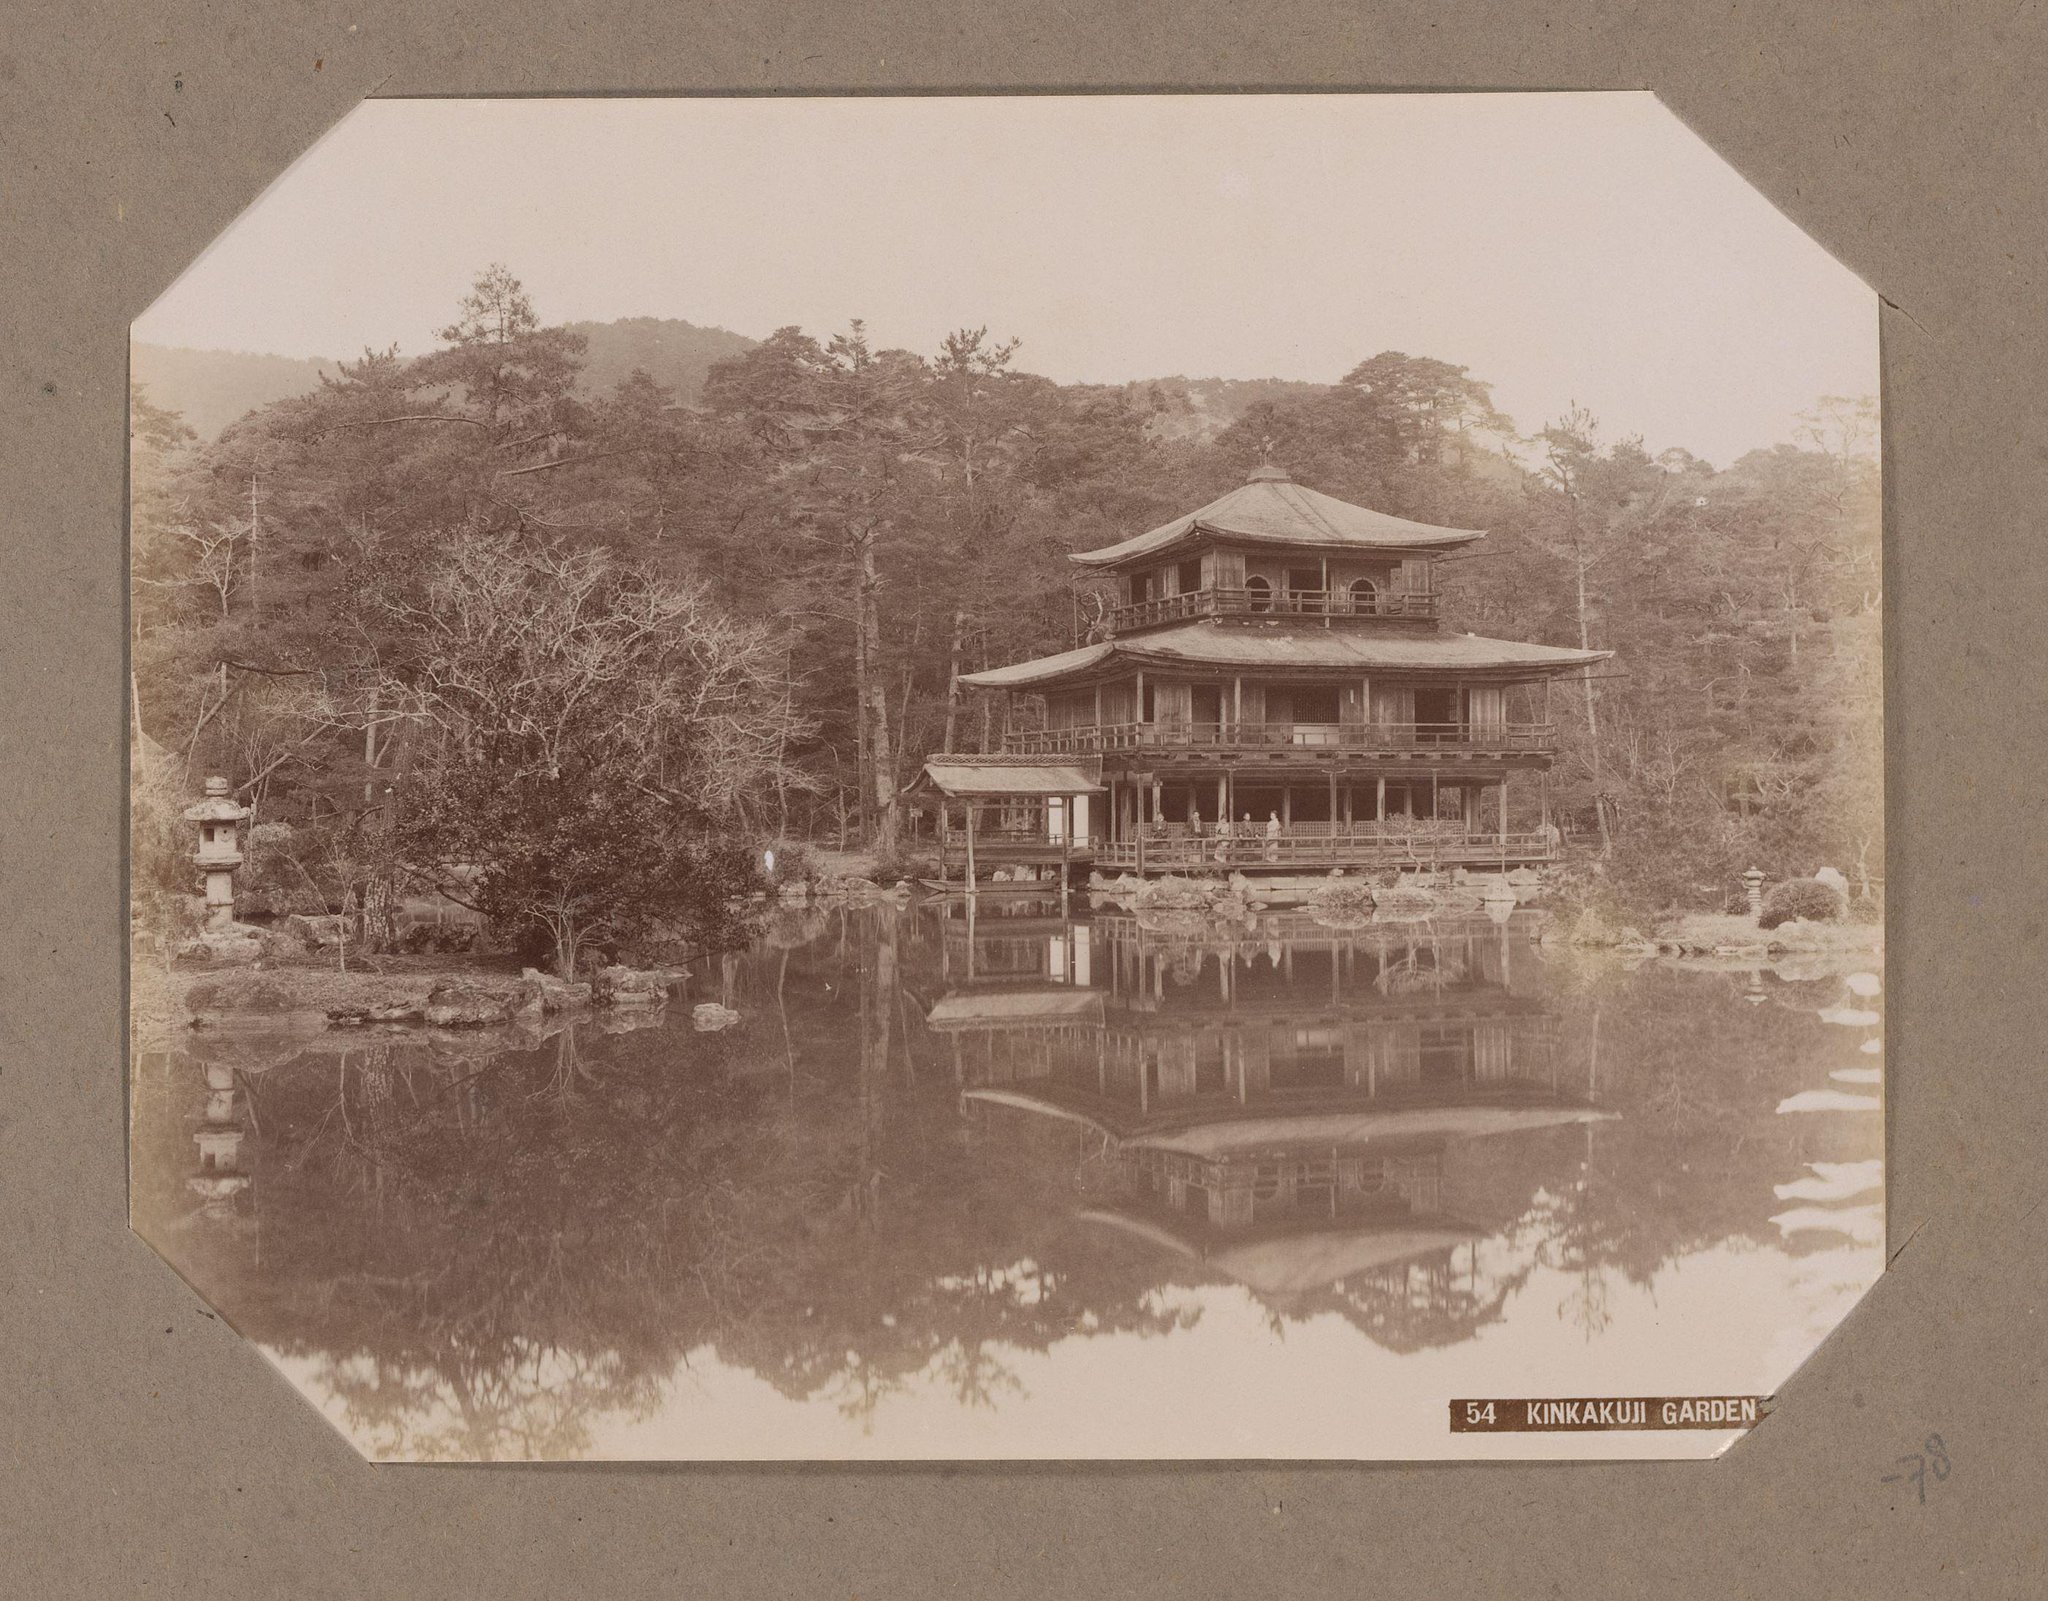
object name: album leaf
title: Gebouw aan een vijver in de Kinkaku-ji tuin in Kyoto, Japan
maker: Anonymous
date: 1890-1903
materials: paper, photographic support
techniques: albumen print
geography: kyoto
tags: trees, garden pond, civic architecture; edifices; dwellings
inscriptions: inscription: ‘54 Kinkakuji Garden - Kioto’